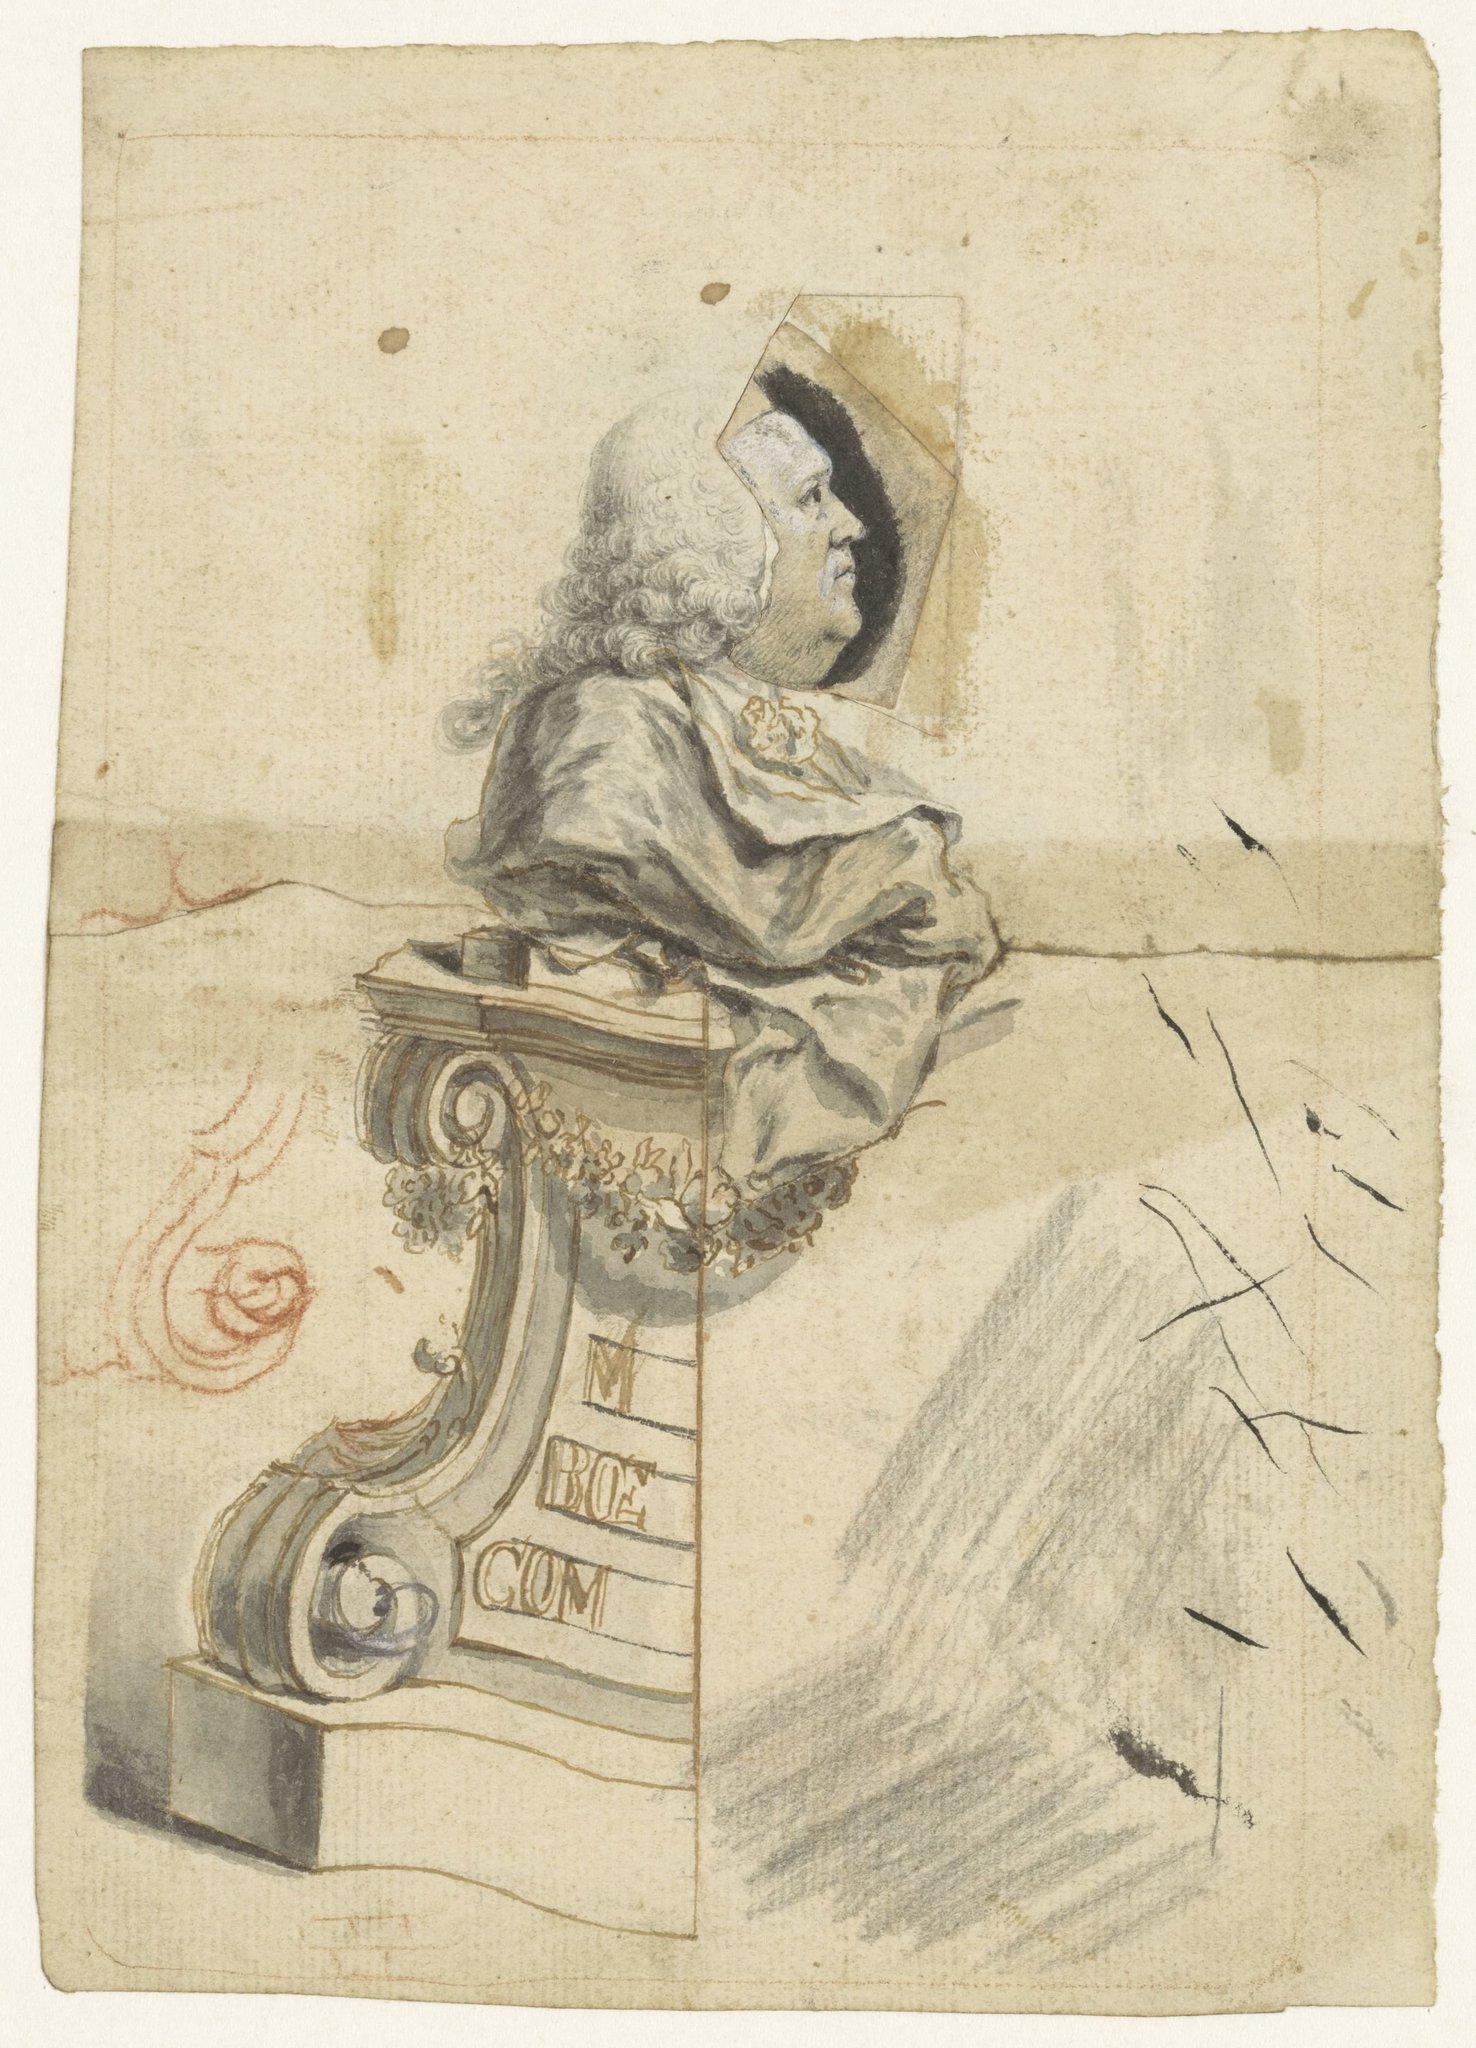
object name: drawing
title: Portret van Gerard van Swieten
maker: augustin cipps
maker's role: draughtsman, print maker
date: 1700-1800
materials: chalk, ink, paper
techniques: brush, pen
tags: leiden, historical persons, physician, doctor